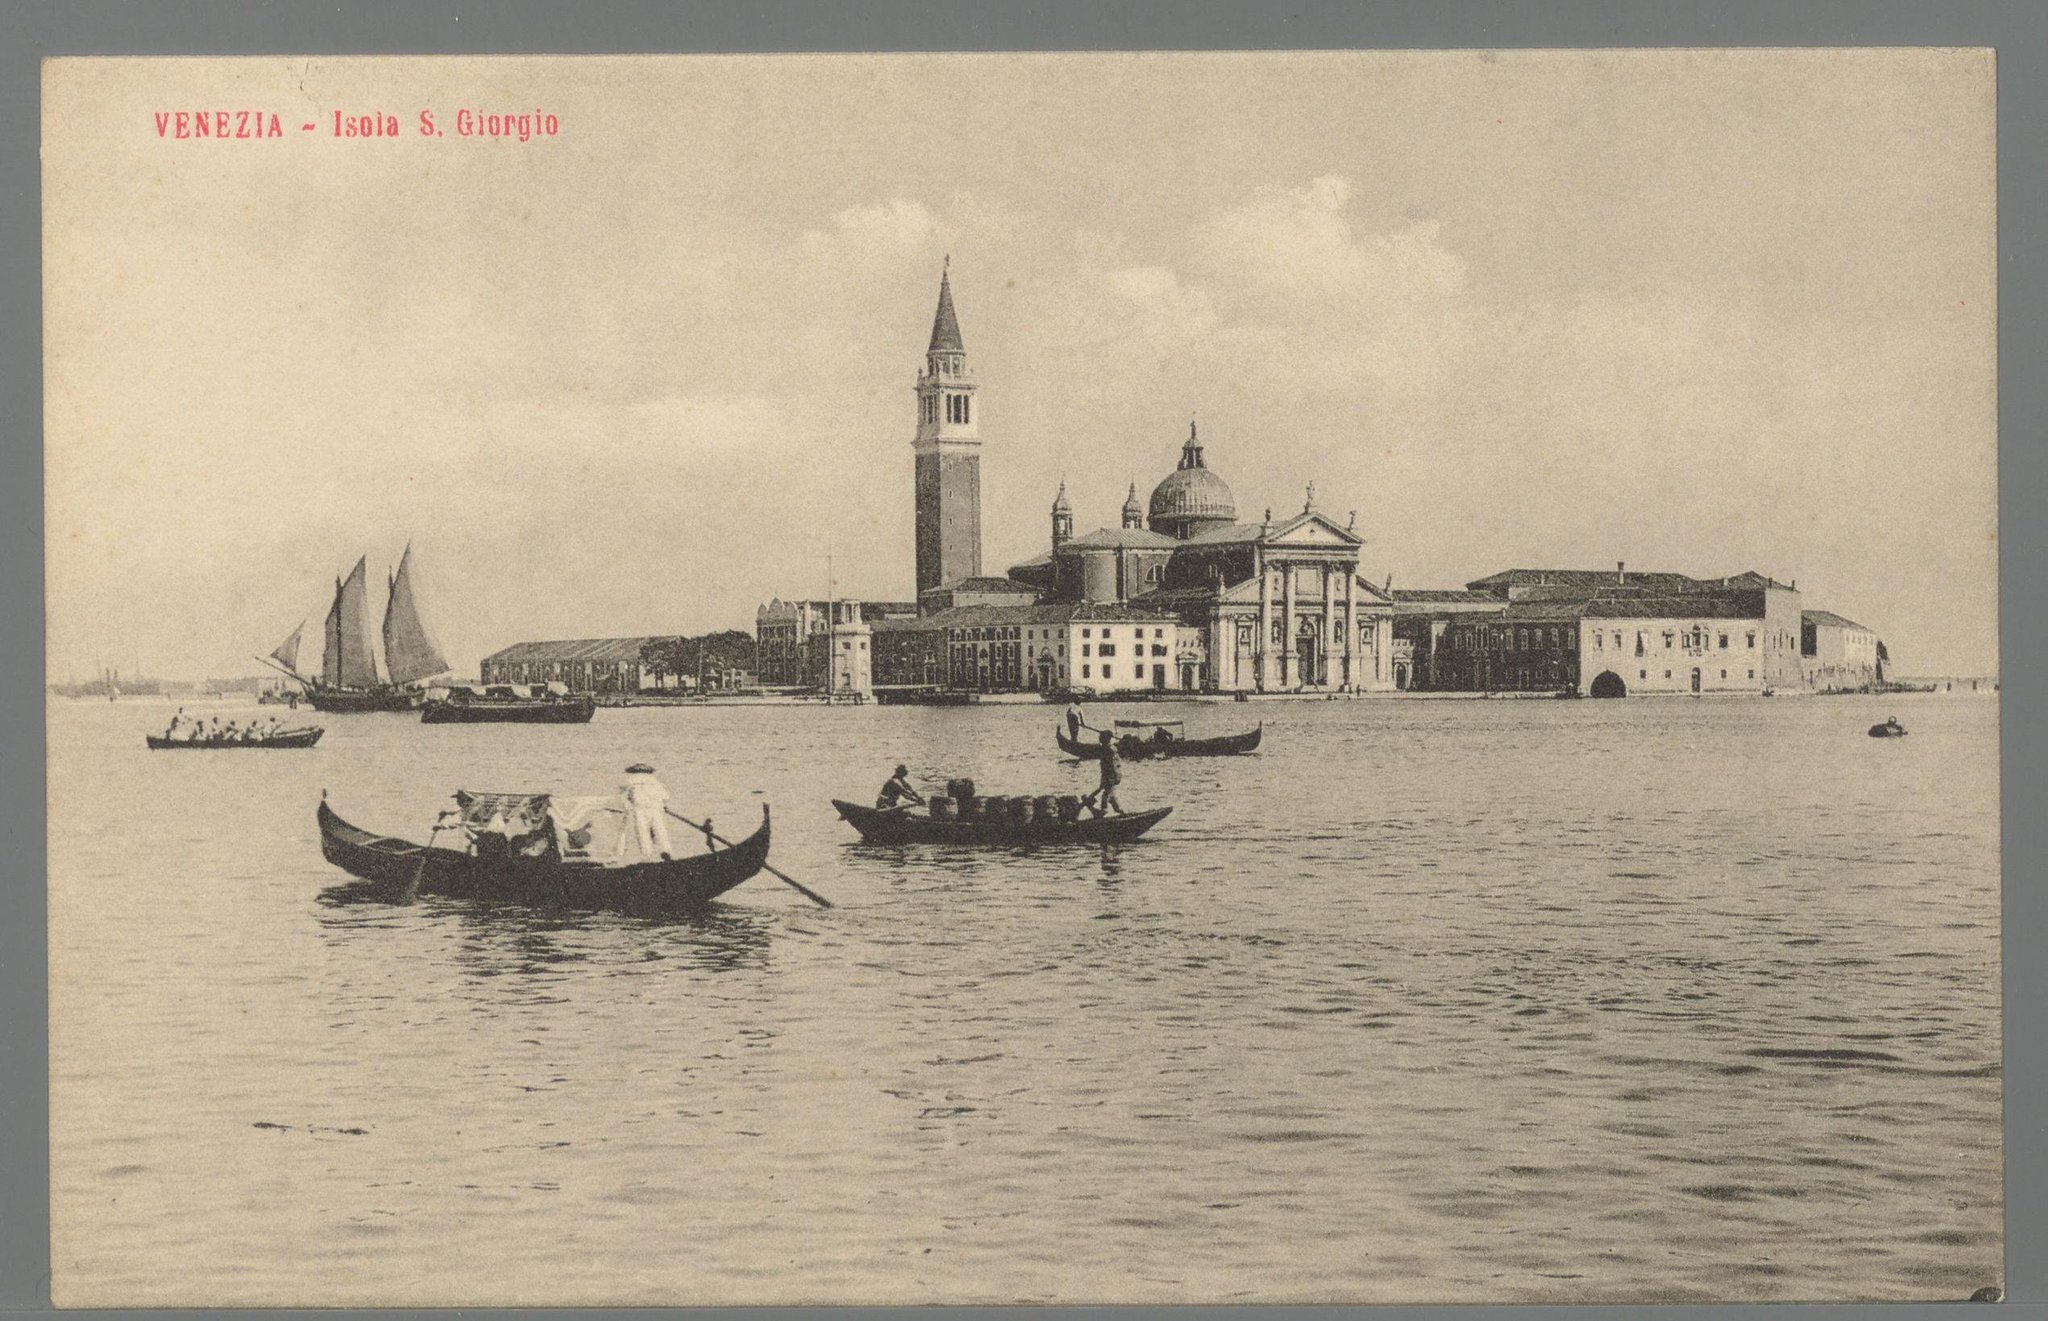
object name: ansichtkaart, prentbriefkaart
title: Venezia. Isola S. Giorgio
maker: Anonymous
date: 1906-1920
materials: cardboard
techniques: photograph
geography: venice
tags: landscapes with waters, waterscapes, seascapes (in the temperate zone), church (exterior), city-view, and landscape with man-made constructions (+ city(-scape) with figures, staffage)